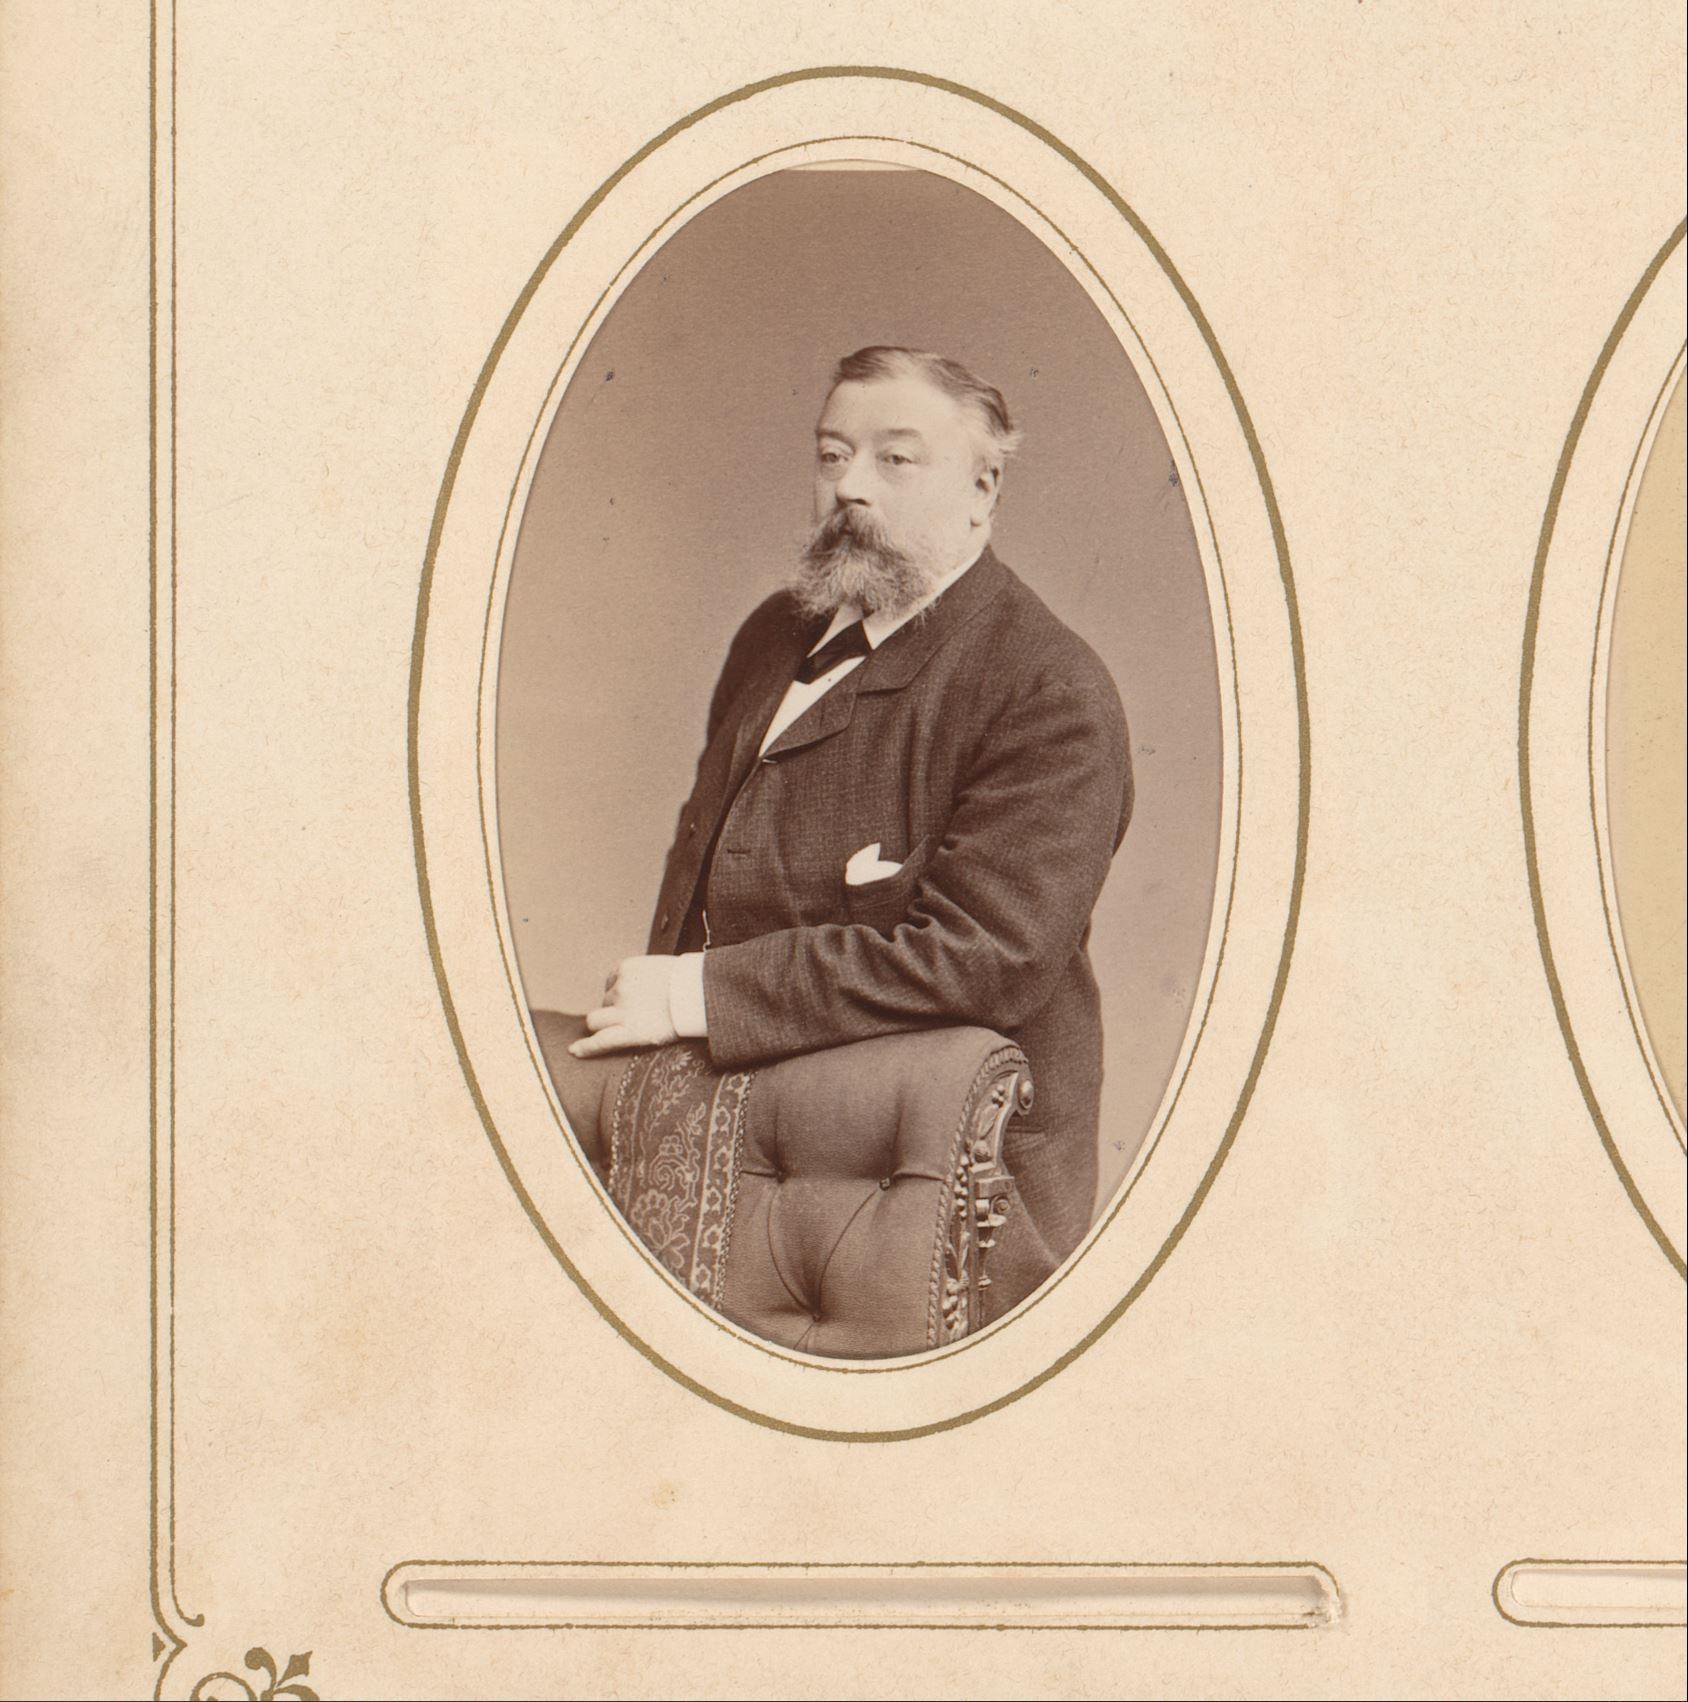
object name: carte de visite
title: Portret van een man, leunend op de rugleuning van een fauteuil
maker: emil tiedemann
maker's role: fotograaf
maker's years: 1858-1892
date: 1859-1892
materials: cardboard, photographic support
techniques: albumen print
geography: germany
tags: armchair, seat, historical persons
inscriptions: inscription: ‘EMIL TIEDEMANN/ HOF-PHOTOGRAPH/ (...)’